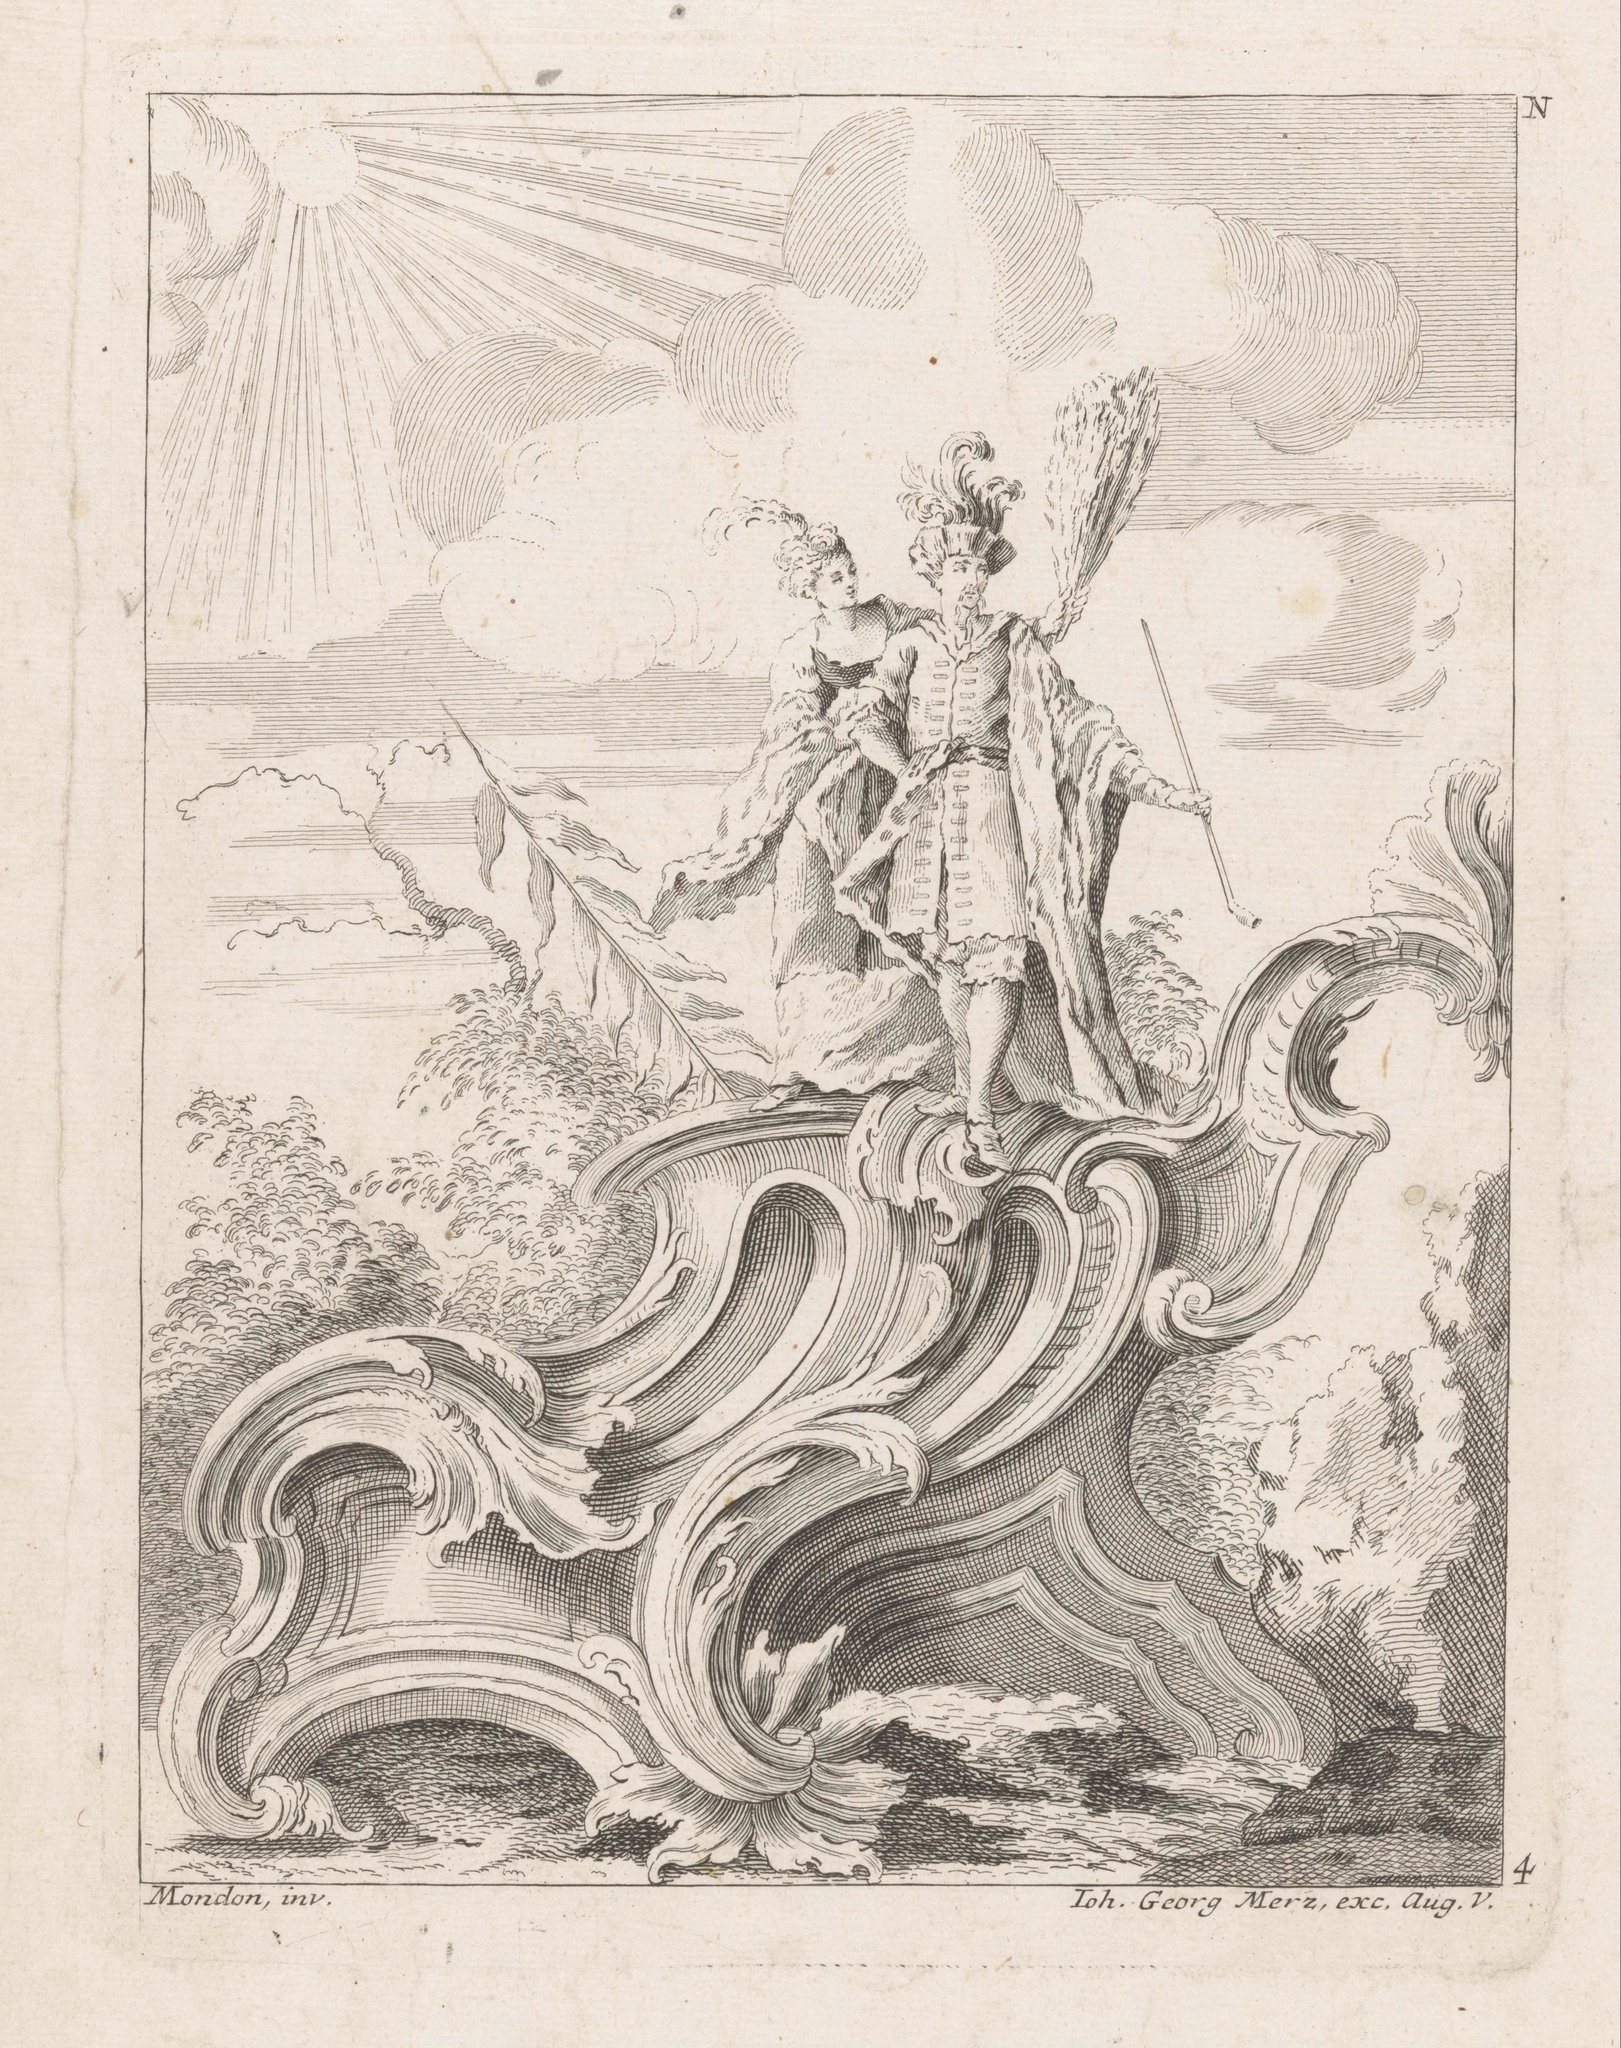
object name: ornament print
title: Man en vrouw op rocaille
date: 1736-1762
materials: paper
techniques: etching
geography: augsburg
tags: rocaille ornament, couple of lovers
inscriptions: collector's mark: Lugt 2228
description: Een man met hoofddeksel en lange pijp staat op een rocaille in een landschap. Achter hem staat een vrouw met pluimen in haar hand. Links schijnt de zon door de wolken. Rechts boven N genummerd.